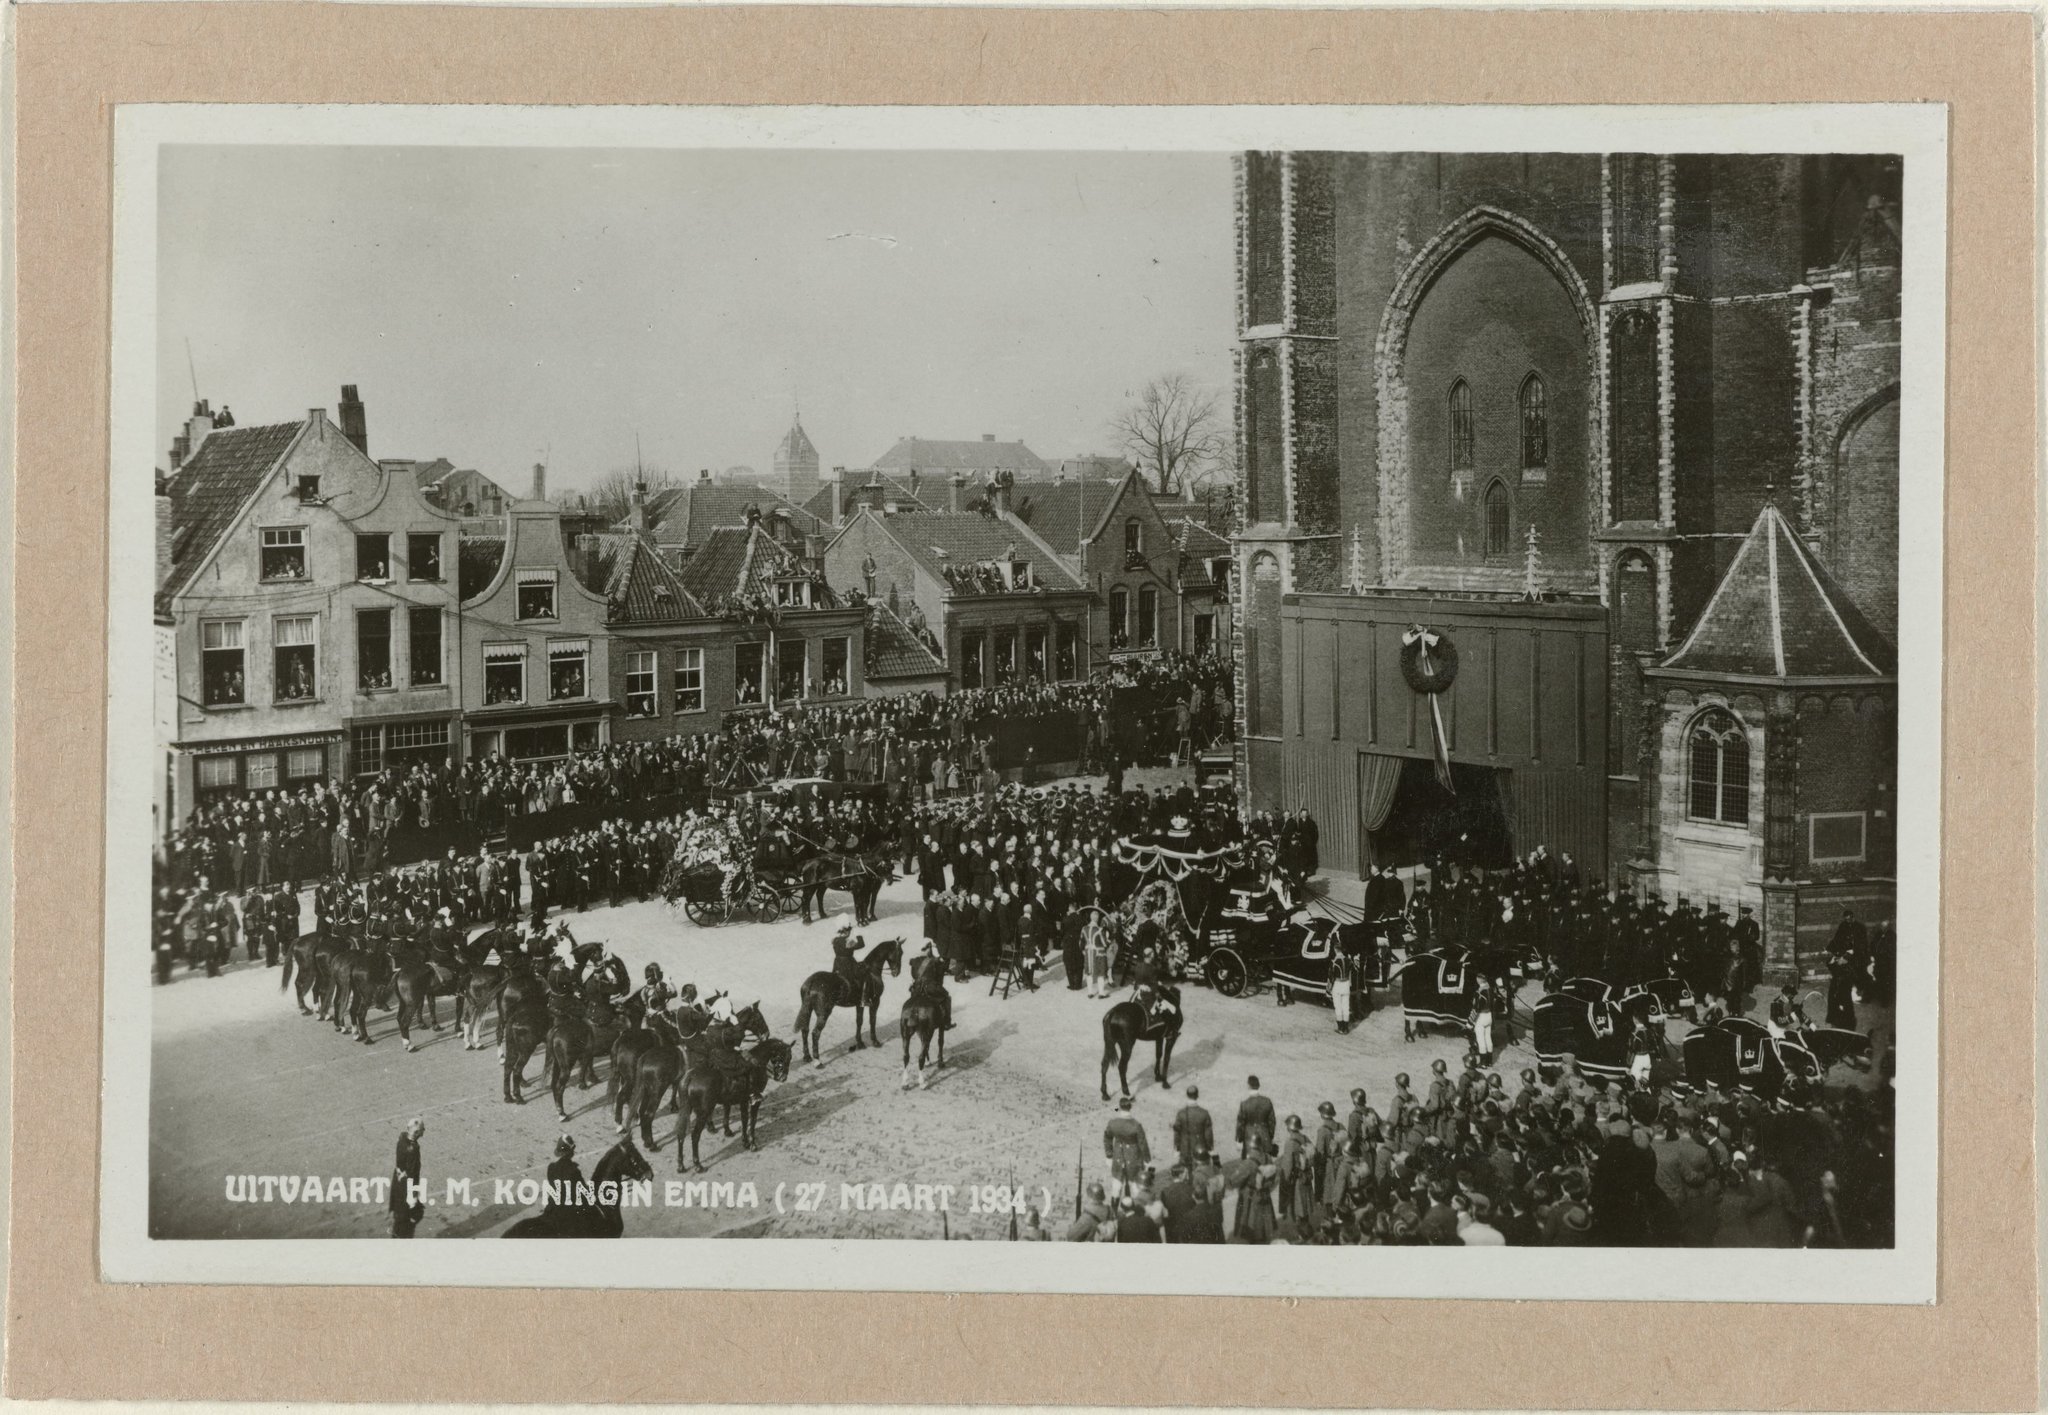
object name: photograph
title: De aankomst voor de Nieuwe Kerk van de begrafenisstoet van Emma, koningin-regentes der Nederlanden, te Delft op 27 maart 1934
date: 1934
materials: photographic support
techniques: photography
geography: amsterdam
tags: emma (queen consort of the netherlands), cortege, funeral procession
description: De aankomst voor de Nieuwe Kerk van de begrafenisstoet van Emma te Delft op 27 maart 1934. Eronder een regel Nederlandse tekst.